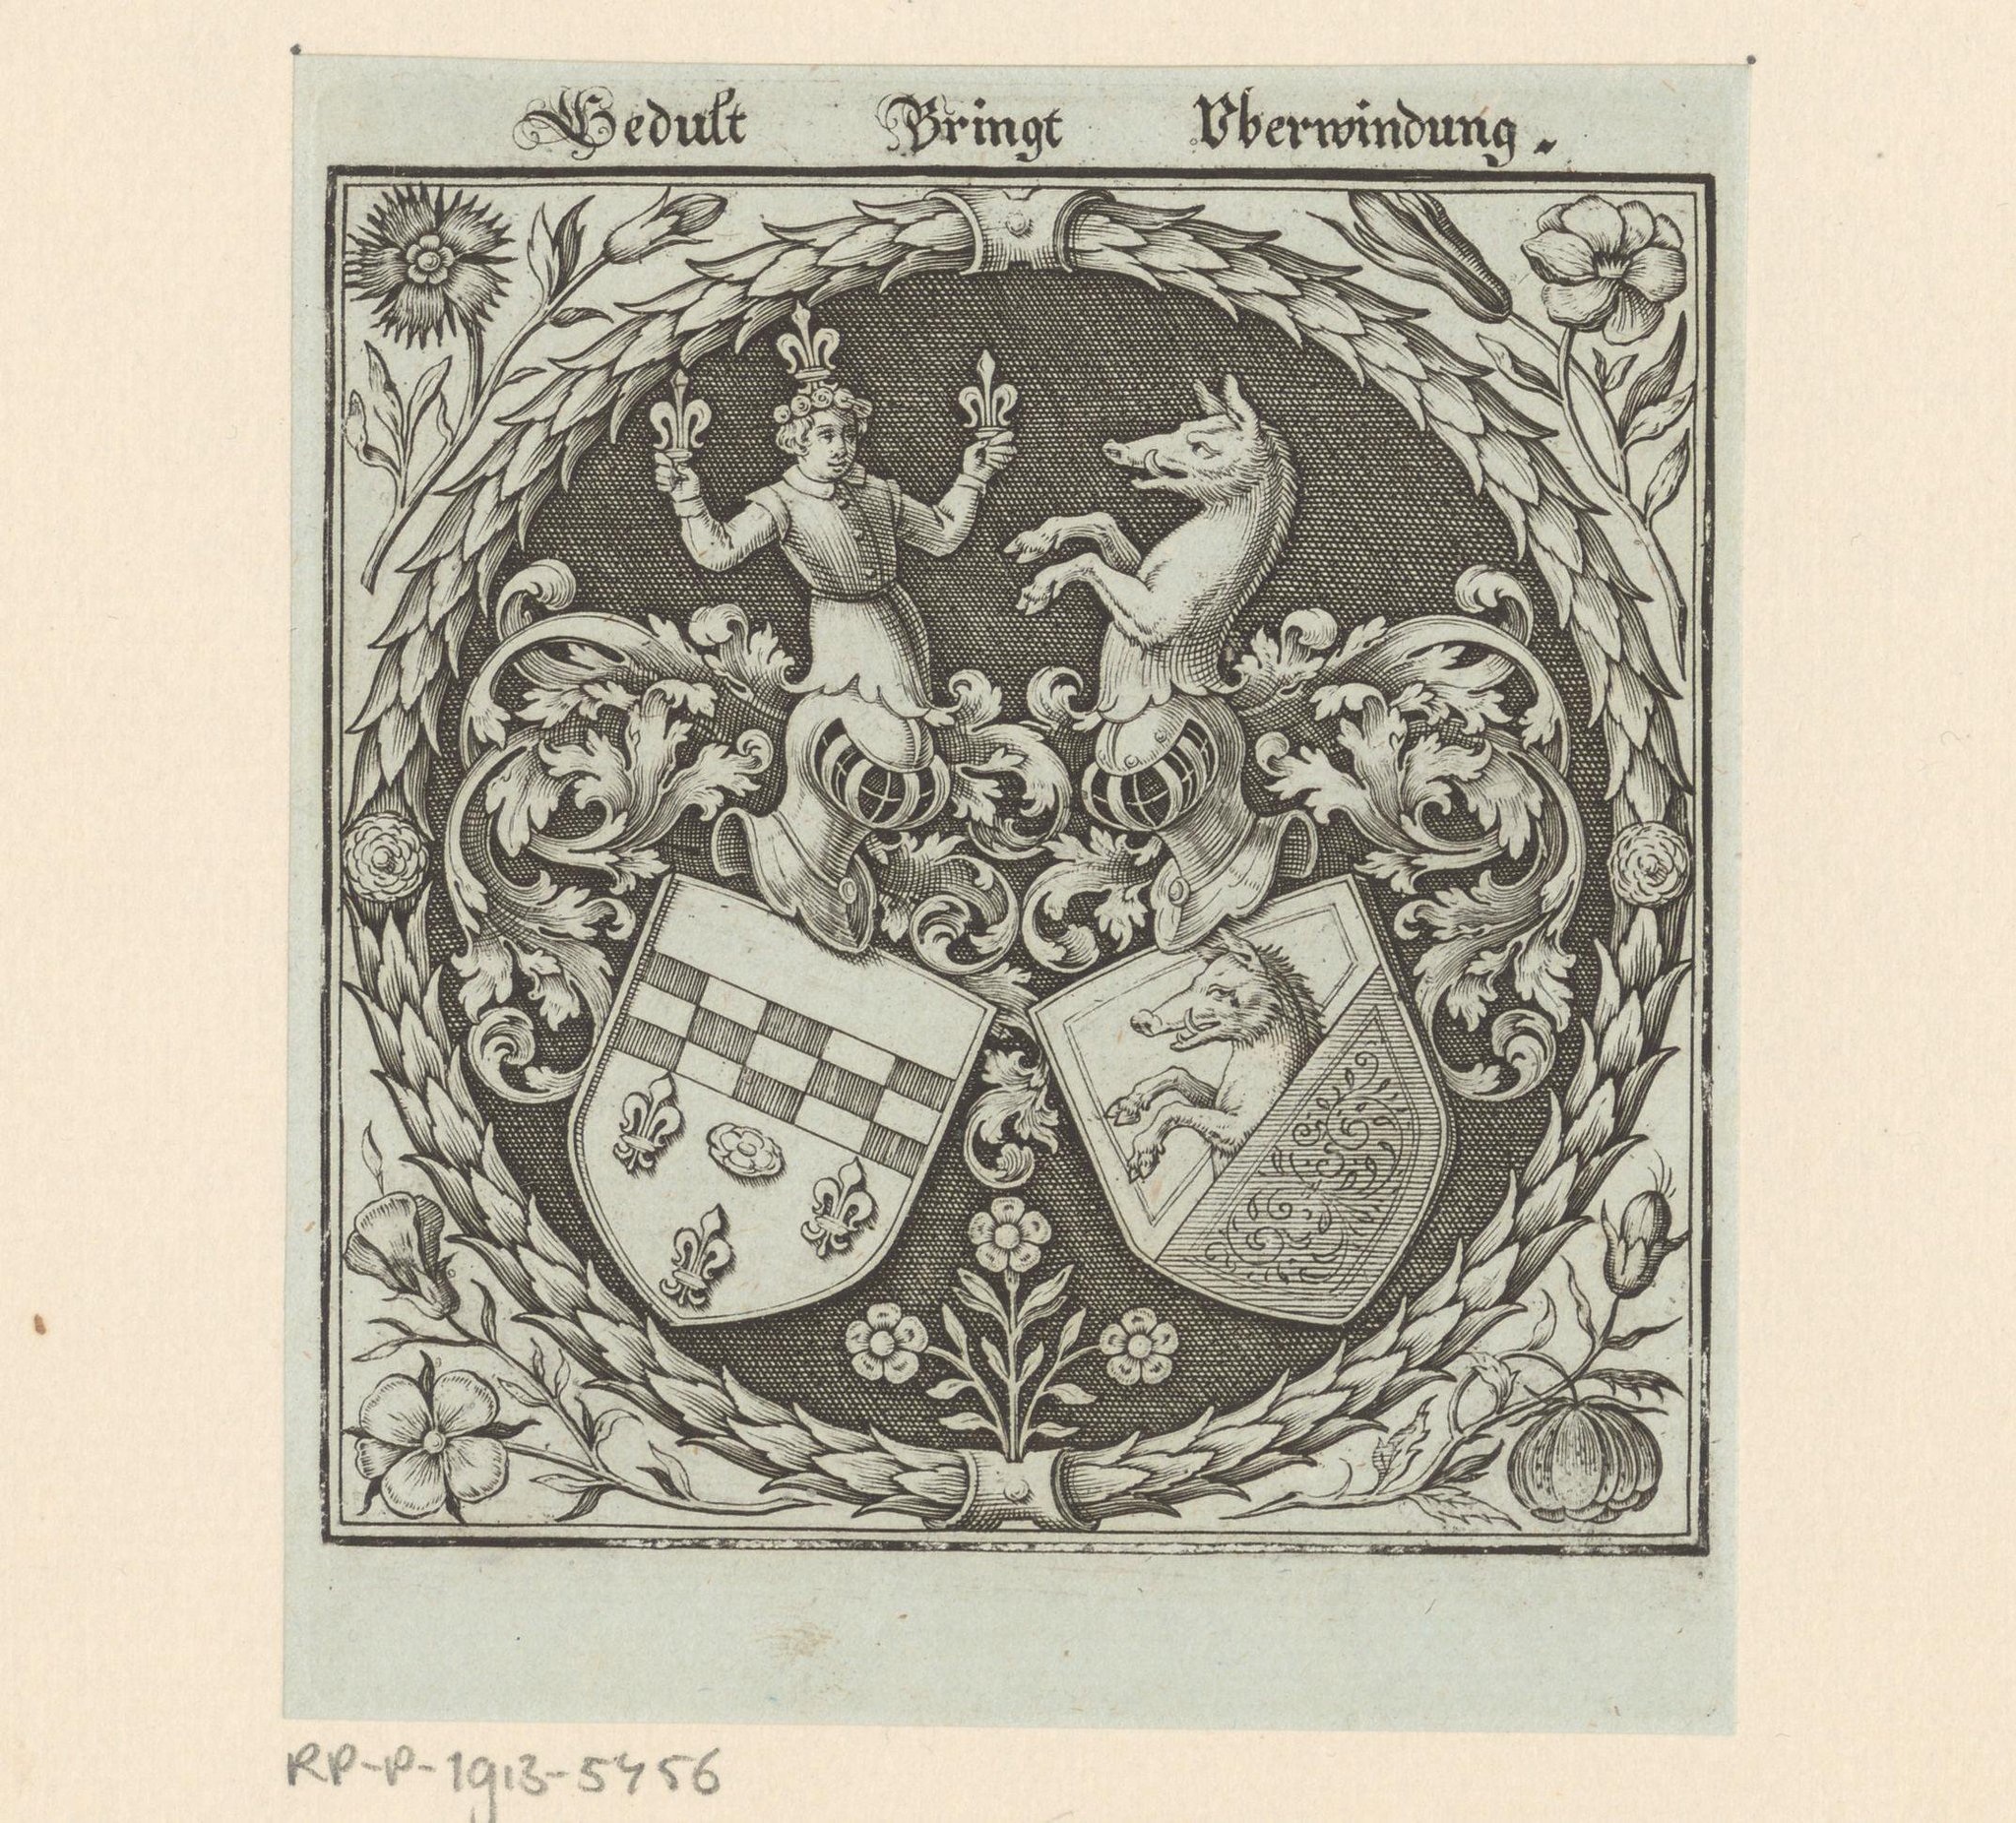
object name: bookplate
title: Gedult bringt Uberwindung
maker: Anonymous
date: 1550-1600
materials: paper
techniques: engraving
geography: switzerland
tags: flowers, hoofed animals: boar, armorial bearing, heraldry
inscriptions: collector's mark: Lugt 2760, collector's mark: Lugt 2233, inscription: ‘Herdruk / Erhardt Clery / Gerster 592’